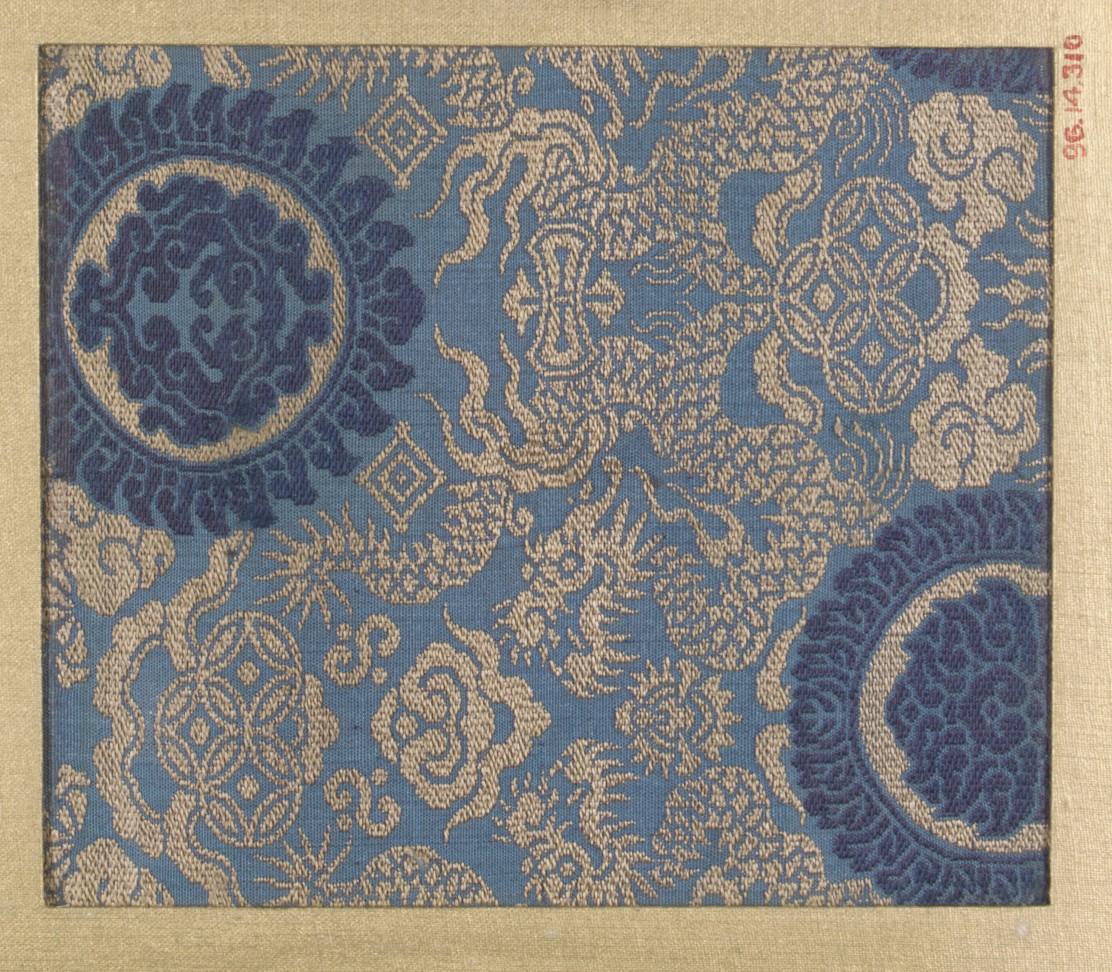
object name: piece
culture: japanese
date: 1701-1900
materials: silk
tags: dragons